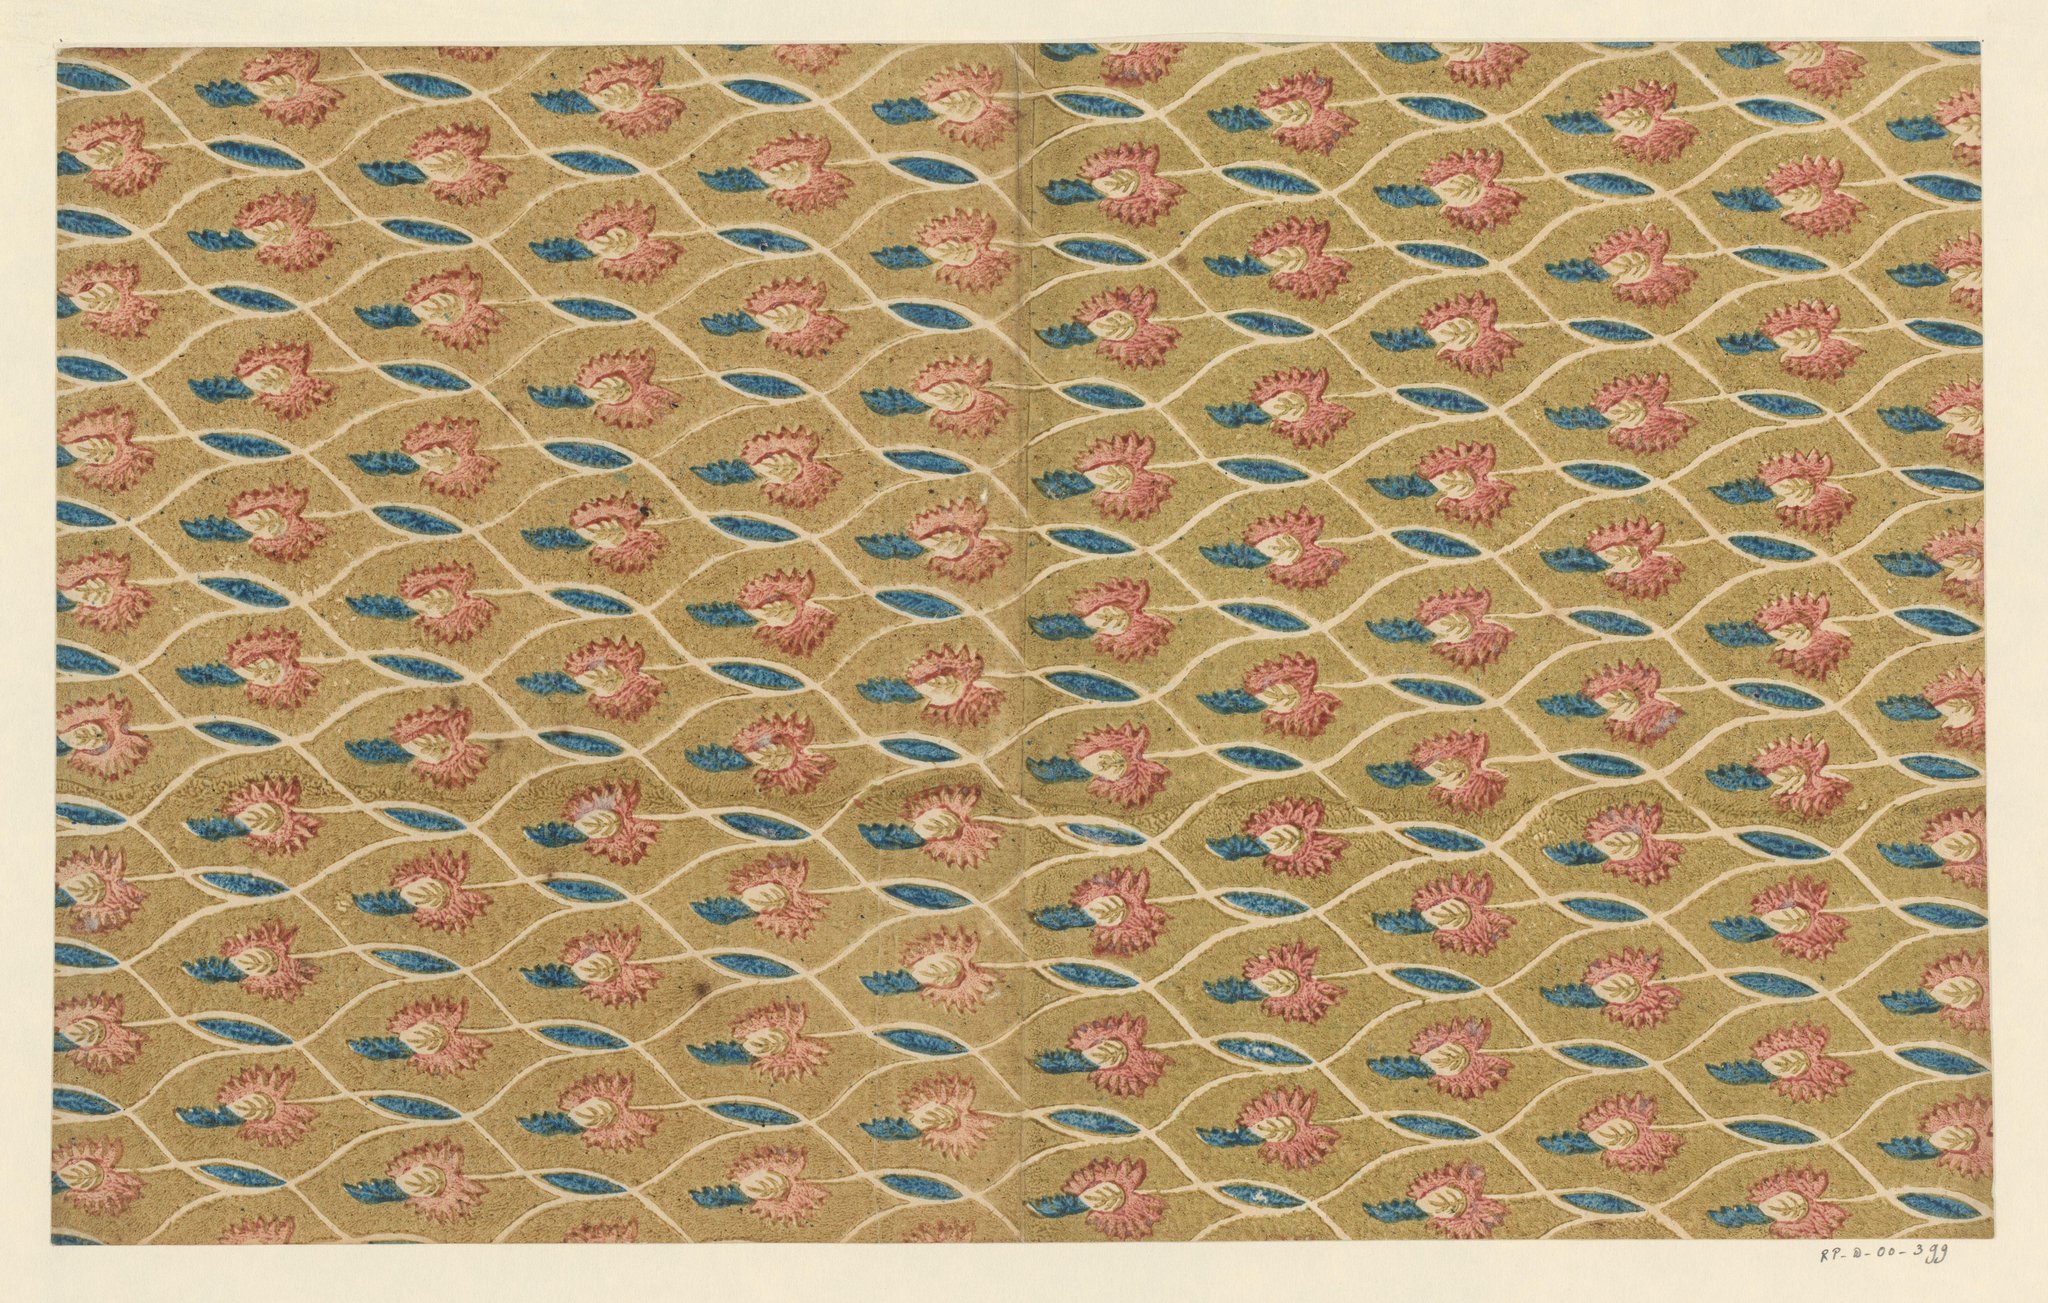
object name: printed paper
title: Blad met uitgespaard motief met bloem met blad tussen slingerende lijnen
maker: Anonymous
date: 1700-1850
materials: paper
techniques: printing block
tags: ornament derived from plant forms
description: Blad met regelmatig uitgespaard motief met bloemen met blad tussen slingerende golvende lijnen.